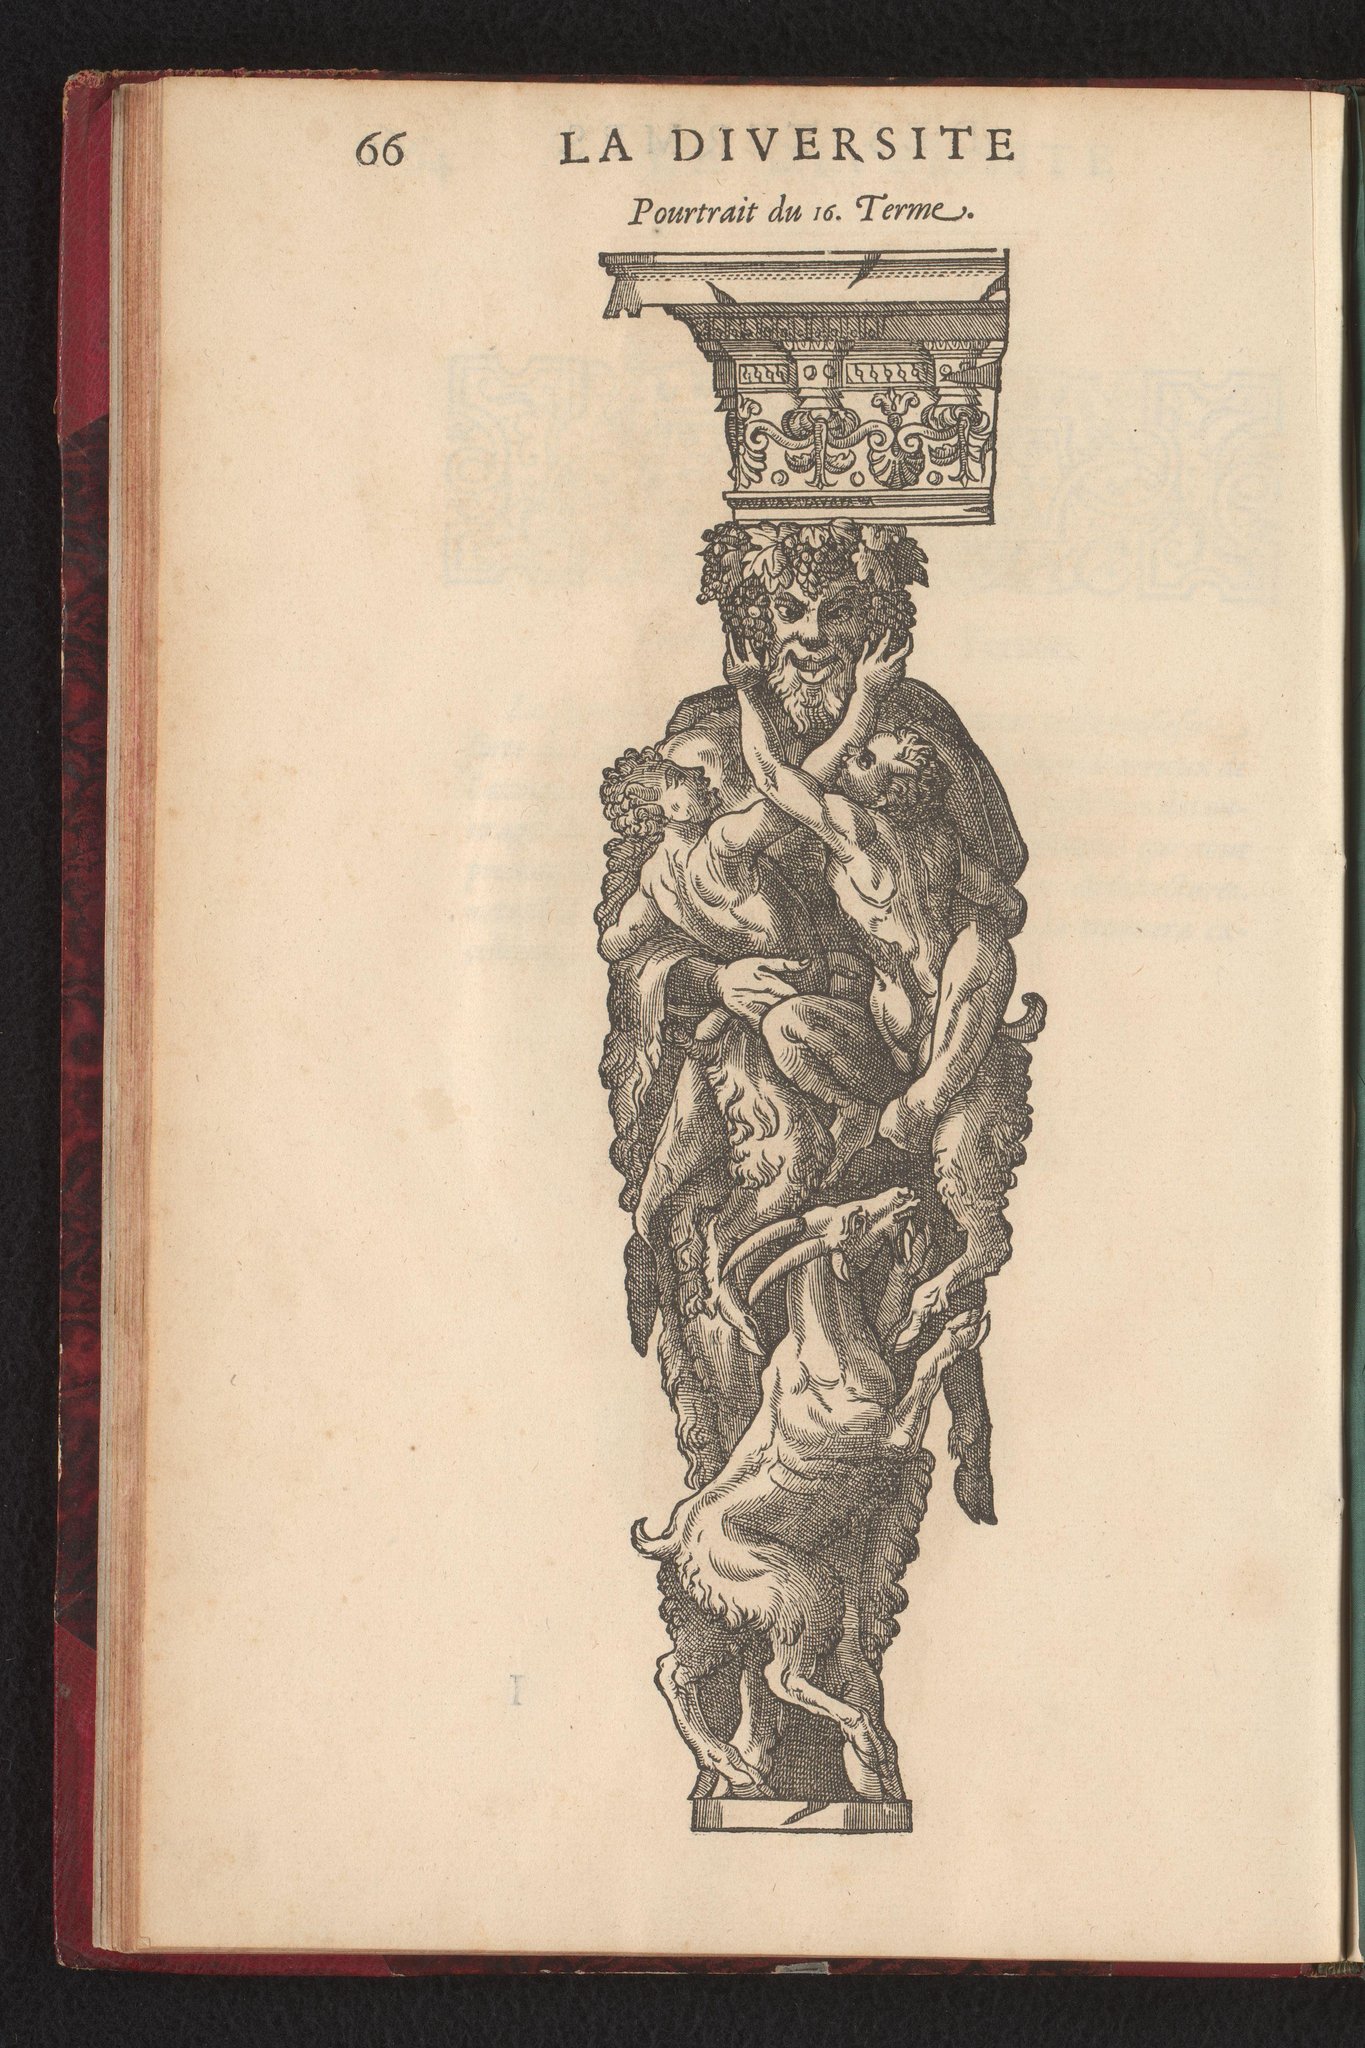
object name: print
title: Pourtrait du 16. Terme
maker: Anonymous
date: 1572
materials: paper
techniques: letterpress printing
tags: herms (garden ornaments), pedestal of a piece of sculpture (perhaps in the form of a herm), satyr(s) (in general), herm: pillar with the head of mercury, patron of travellers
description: De sater draagt twee kleinere saters in zijn armen. Onderaan is een geit te zien. Linksboven genummerd: 66. Volgens de toelichting op pagina 68 gaat het hier om een combinatie van de Dorische, Ionische, Korintische en Composiete orde. Prent maakt deel uit van een album.